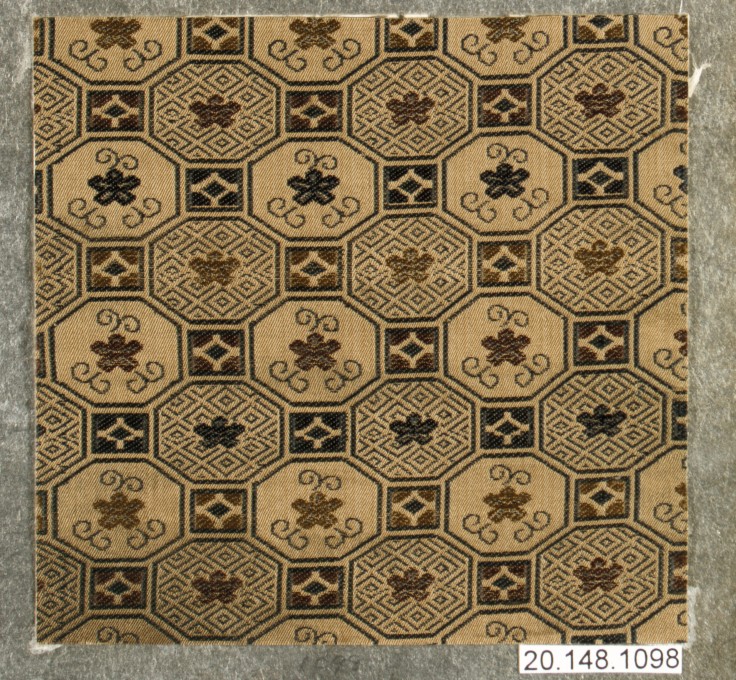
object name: piece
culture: japanese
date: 1701-1800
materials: silk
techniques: compound weave